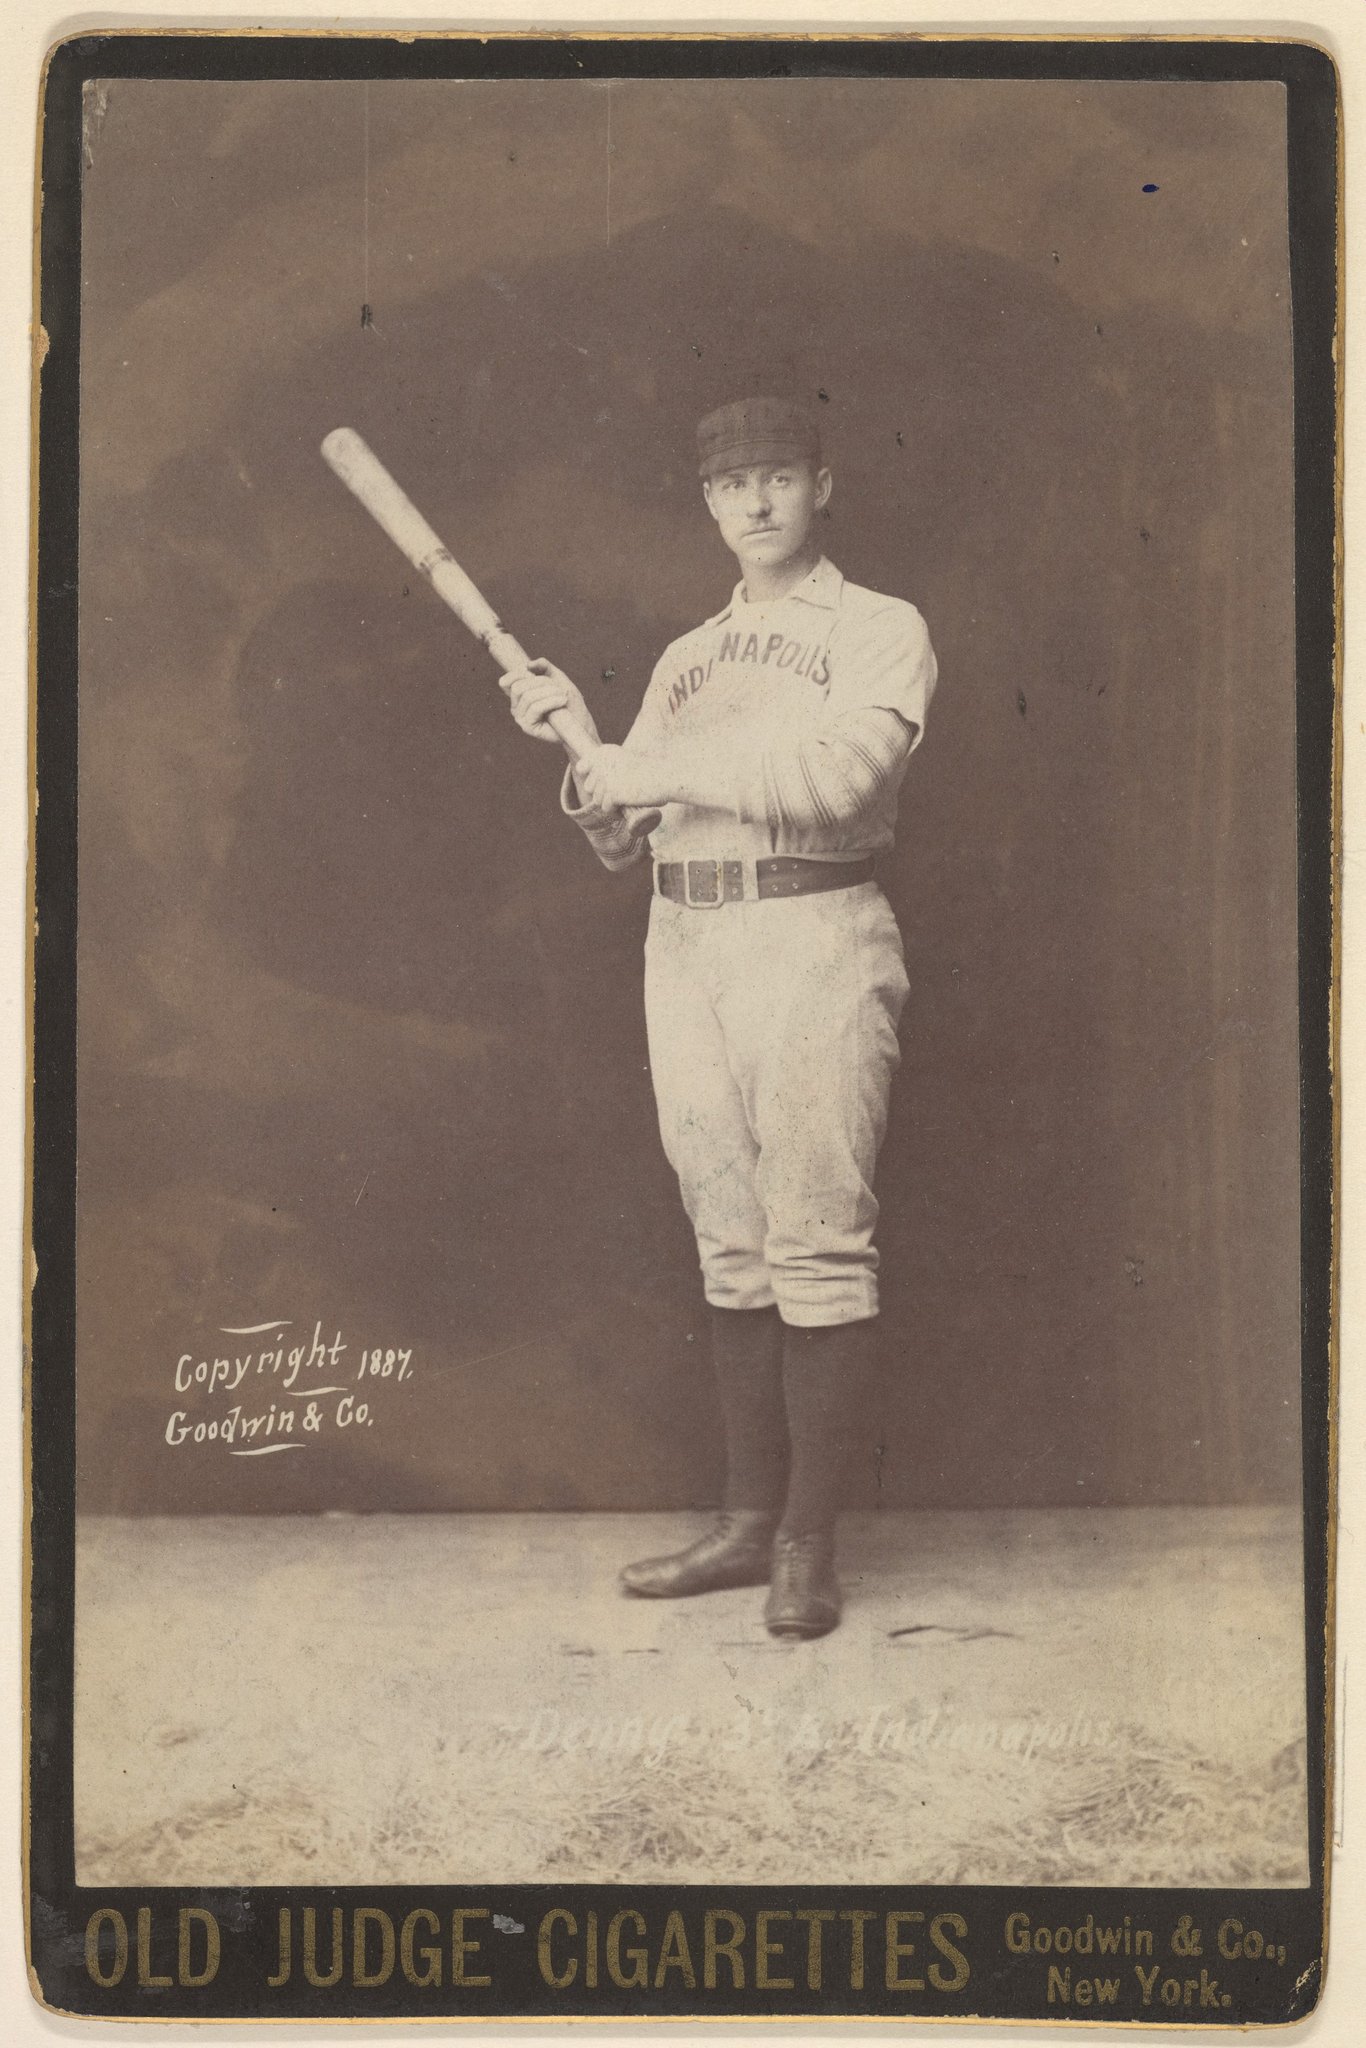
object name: baseball card, photograph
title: Jerry Denny, 3rd Base, Indianapolis, from the series Old Judge Cigarettes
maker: goodwin & company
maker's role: publisher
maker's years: 1850-1950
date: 1887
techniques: albumen silver print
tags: men,portraits,baseball,athletes